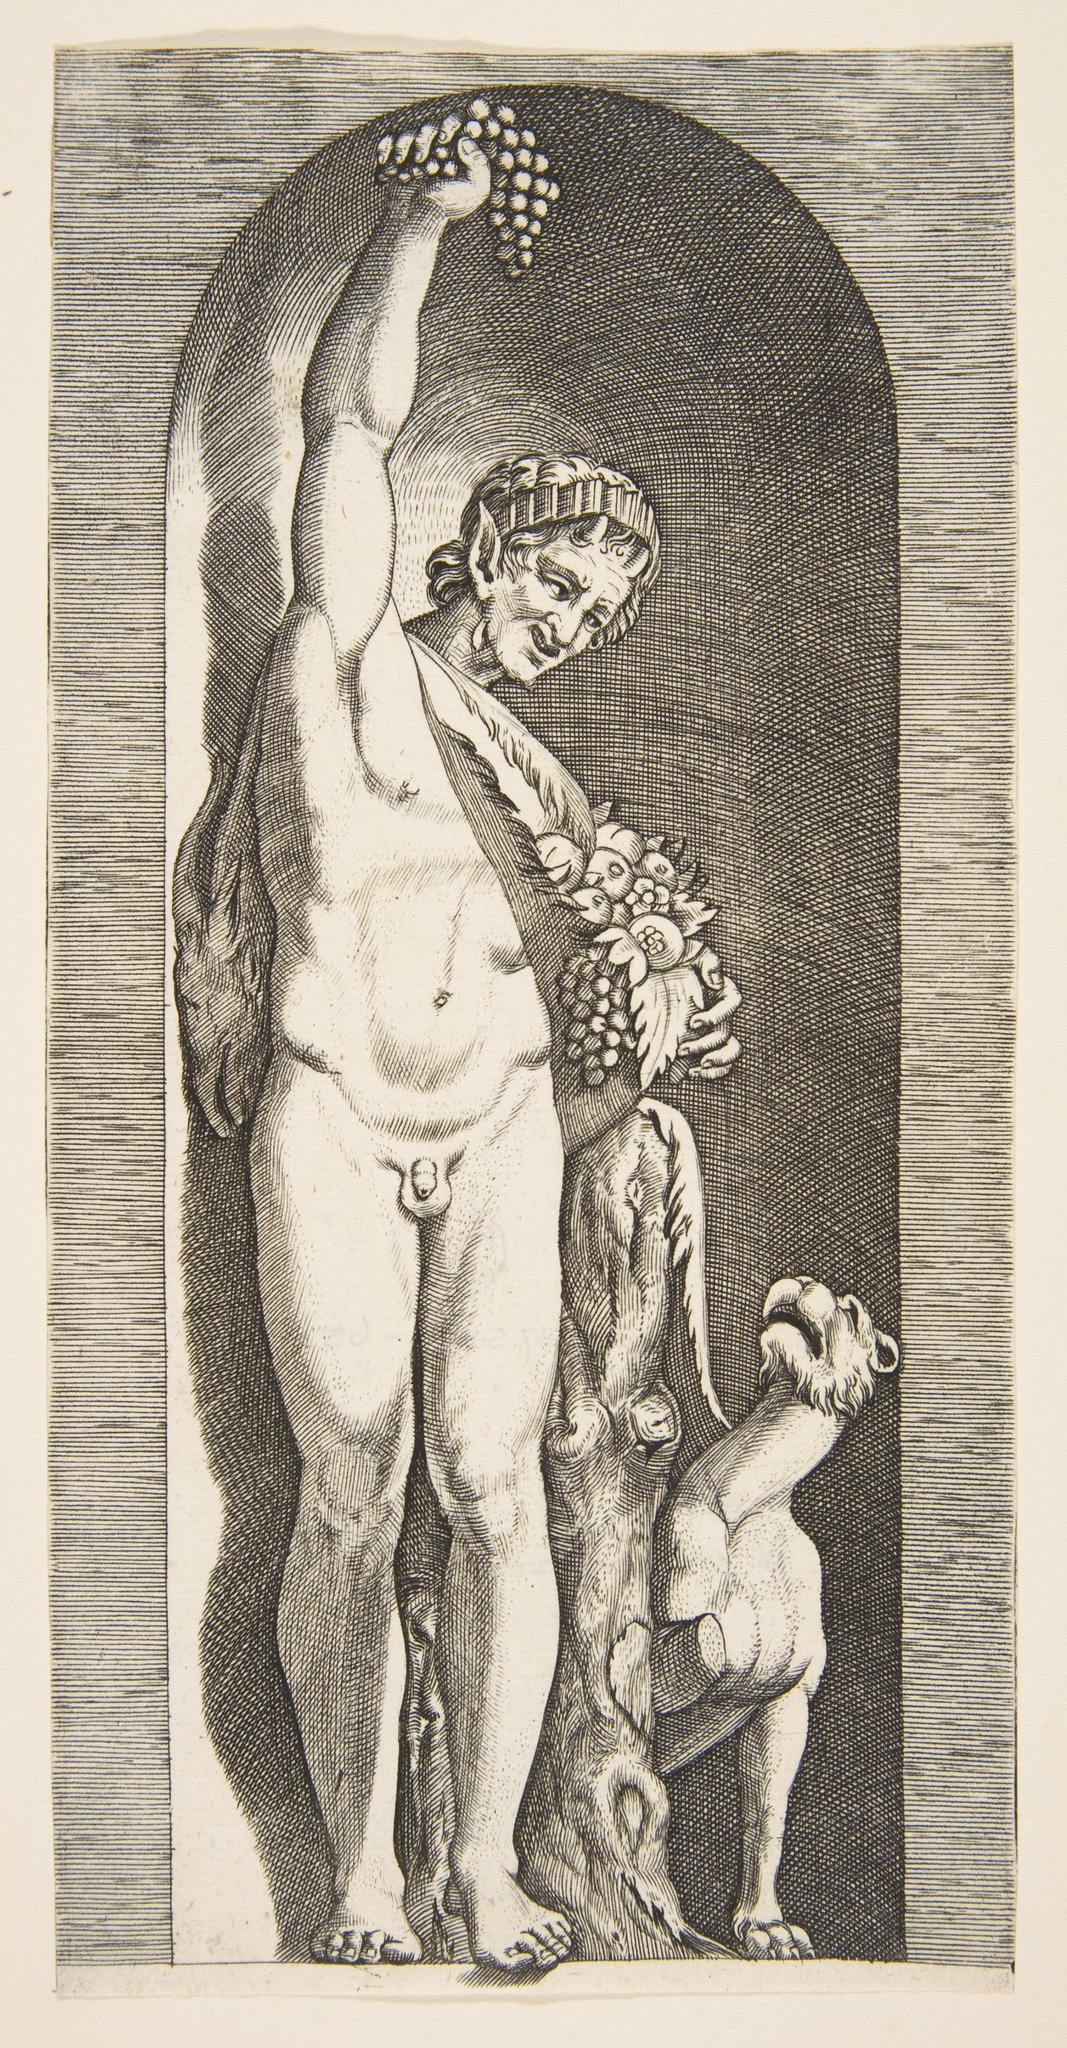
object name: print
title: A faun standing in a niche holding aloft a bunch of grapes with his right hand and fruit with his left hand, a dog lower right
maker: marco dente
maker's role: artist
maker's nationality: italian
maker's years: 1515-1527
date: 1515-1527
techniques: engraving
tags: grapes,male nudes,fauns,dogs